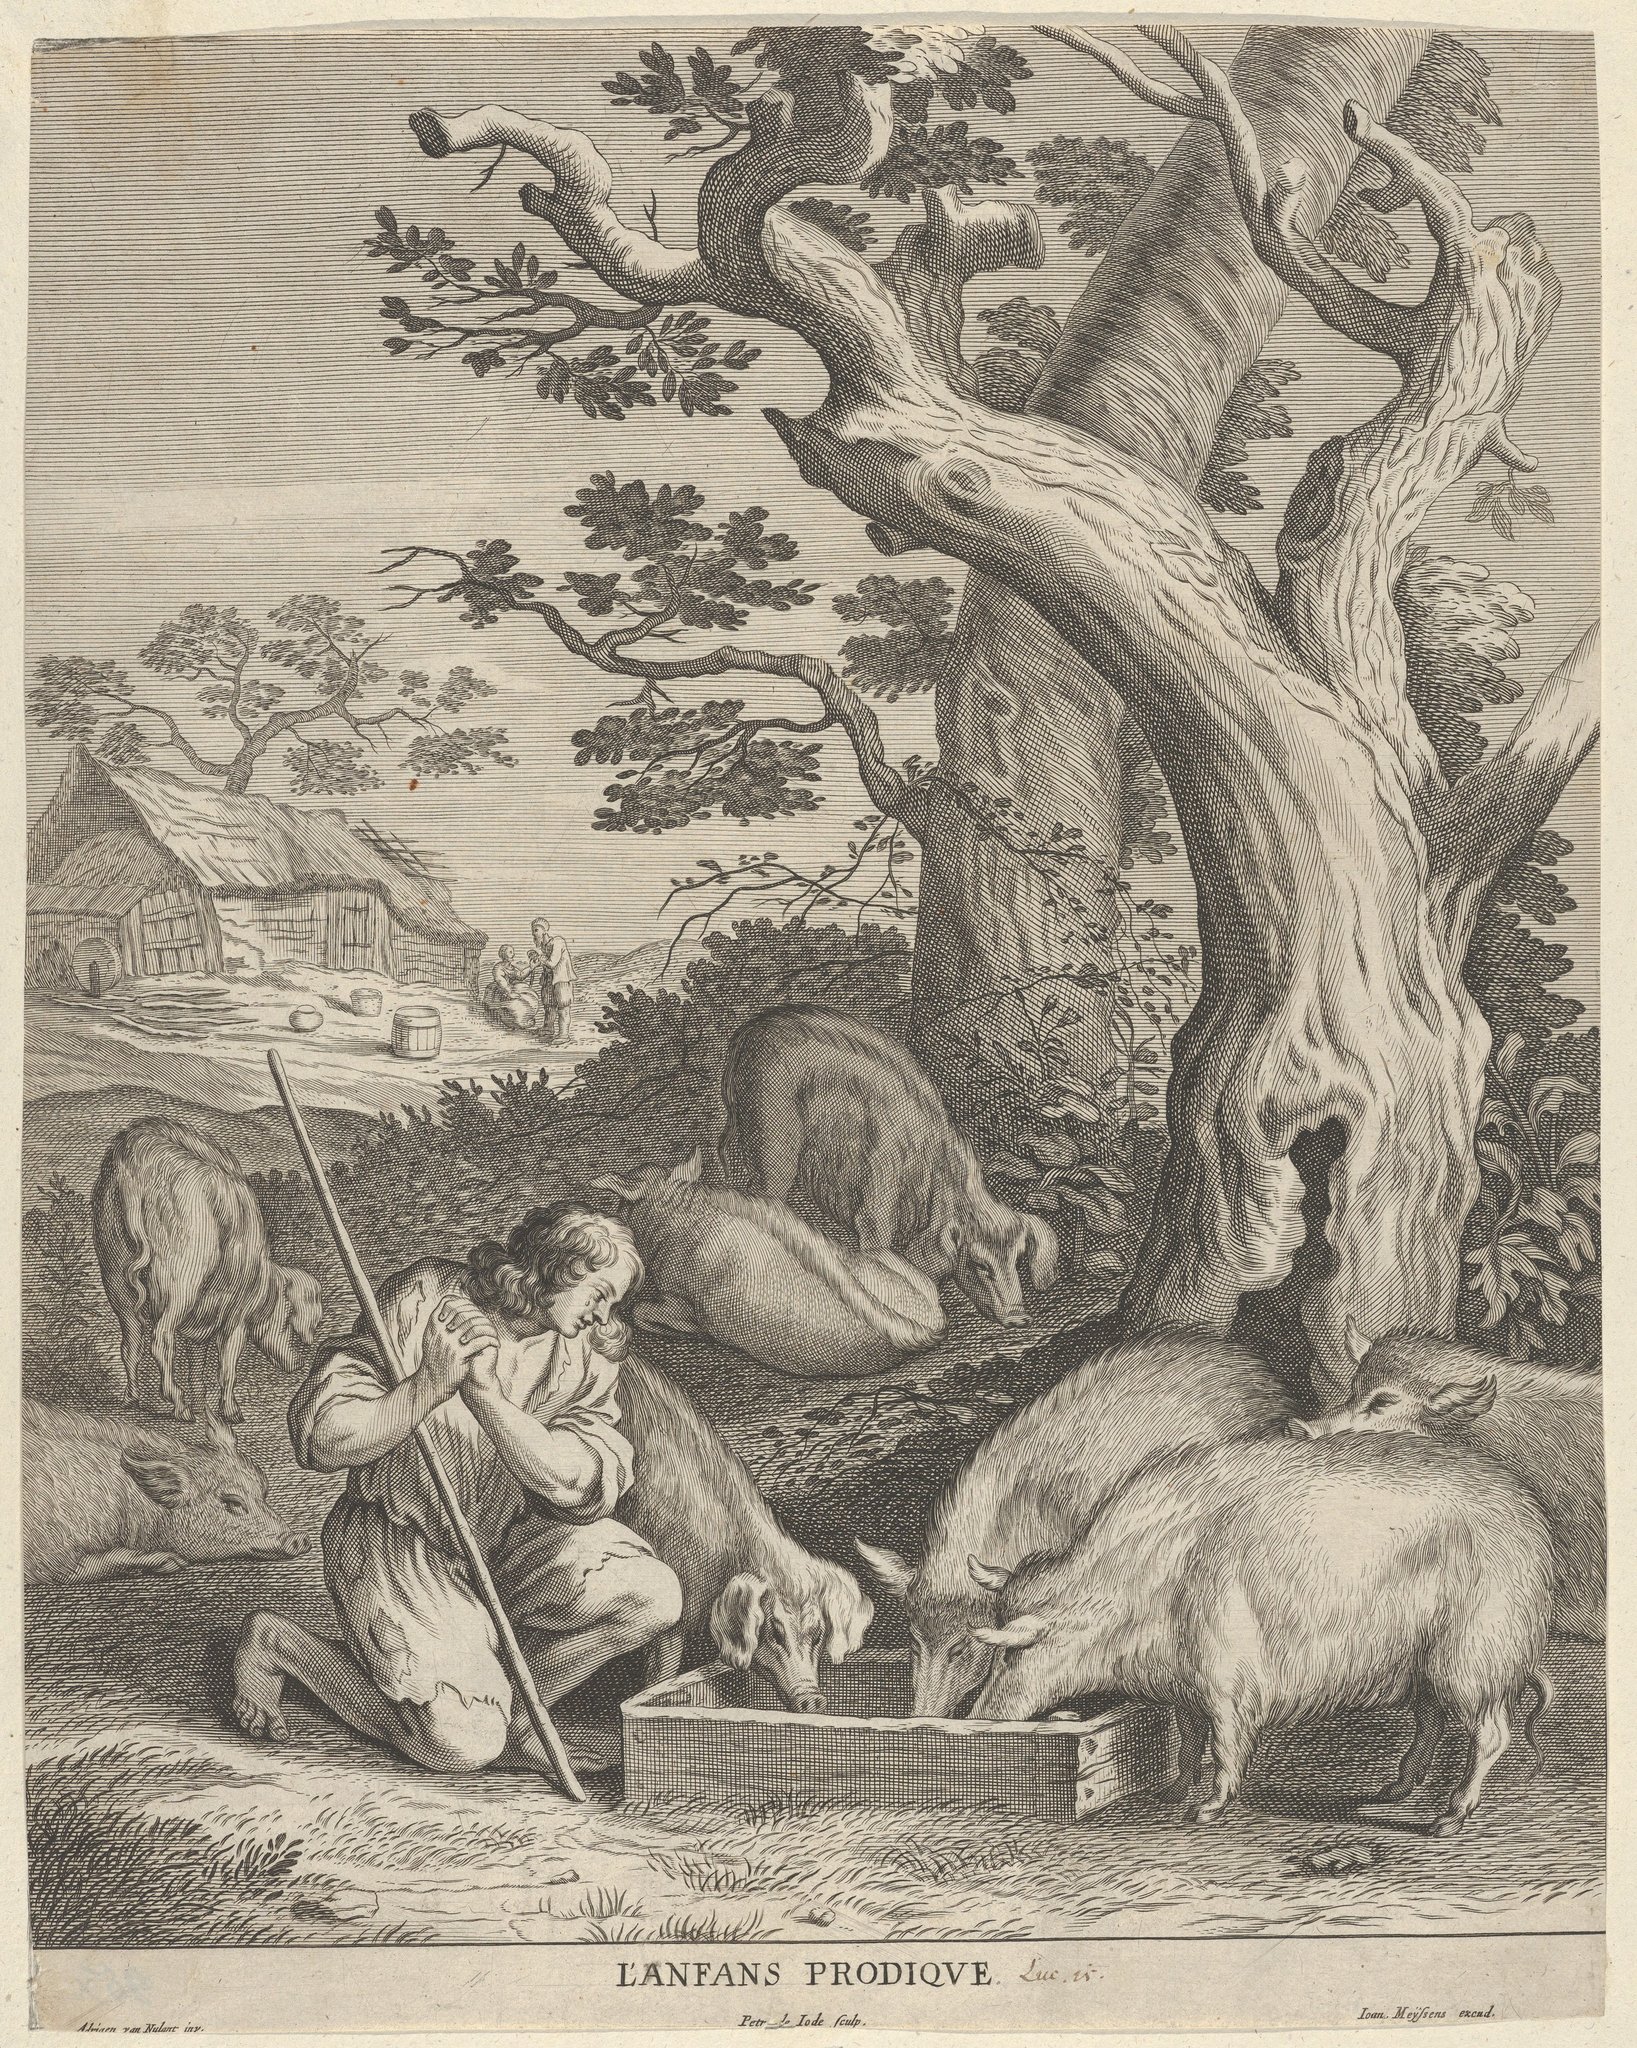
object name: print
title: The Prodigal Son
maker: pieter de jode (ii)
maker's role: artist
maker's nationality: flemish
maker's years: 1606-1674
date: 1601-1700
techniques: engraving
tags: men,pigs,trees